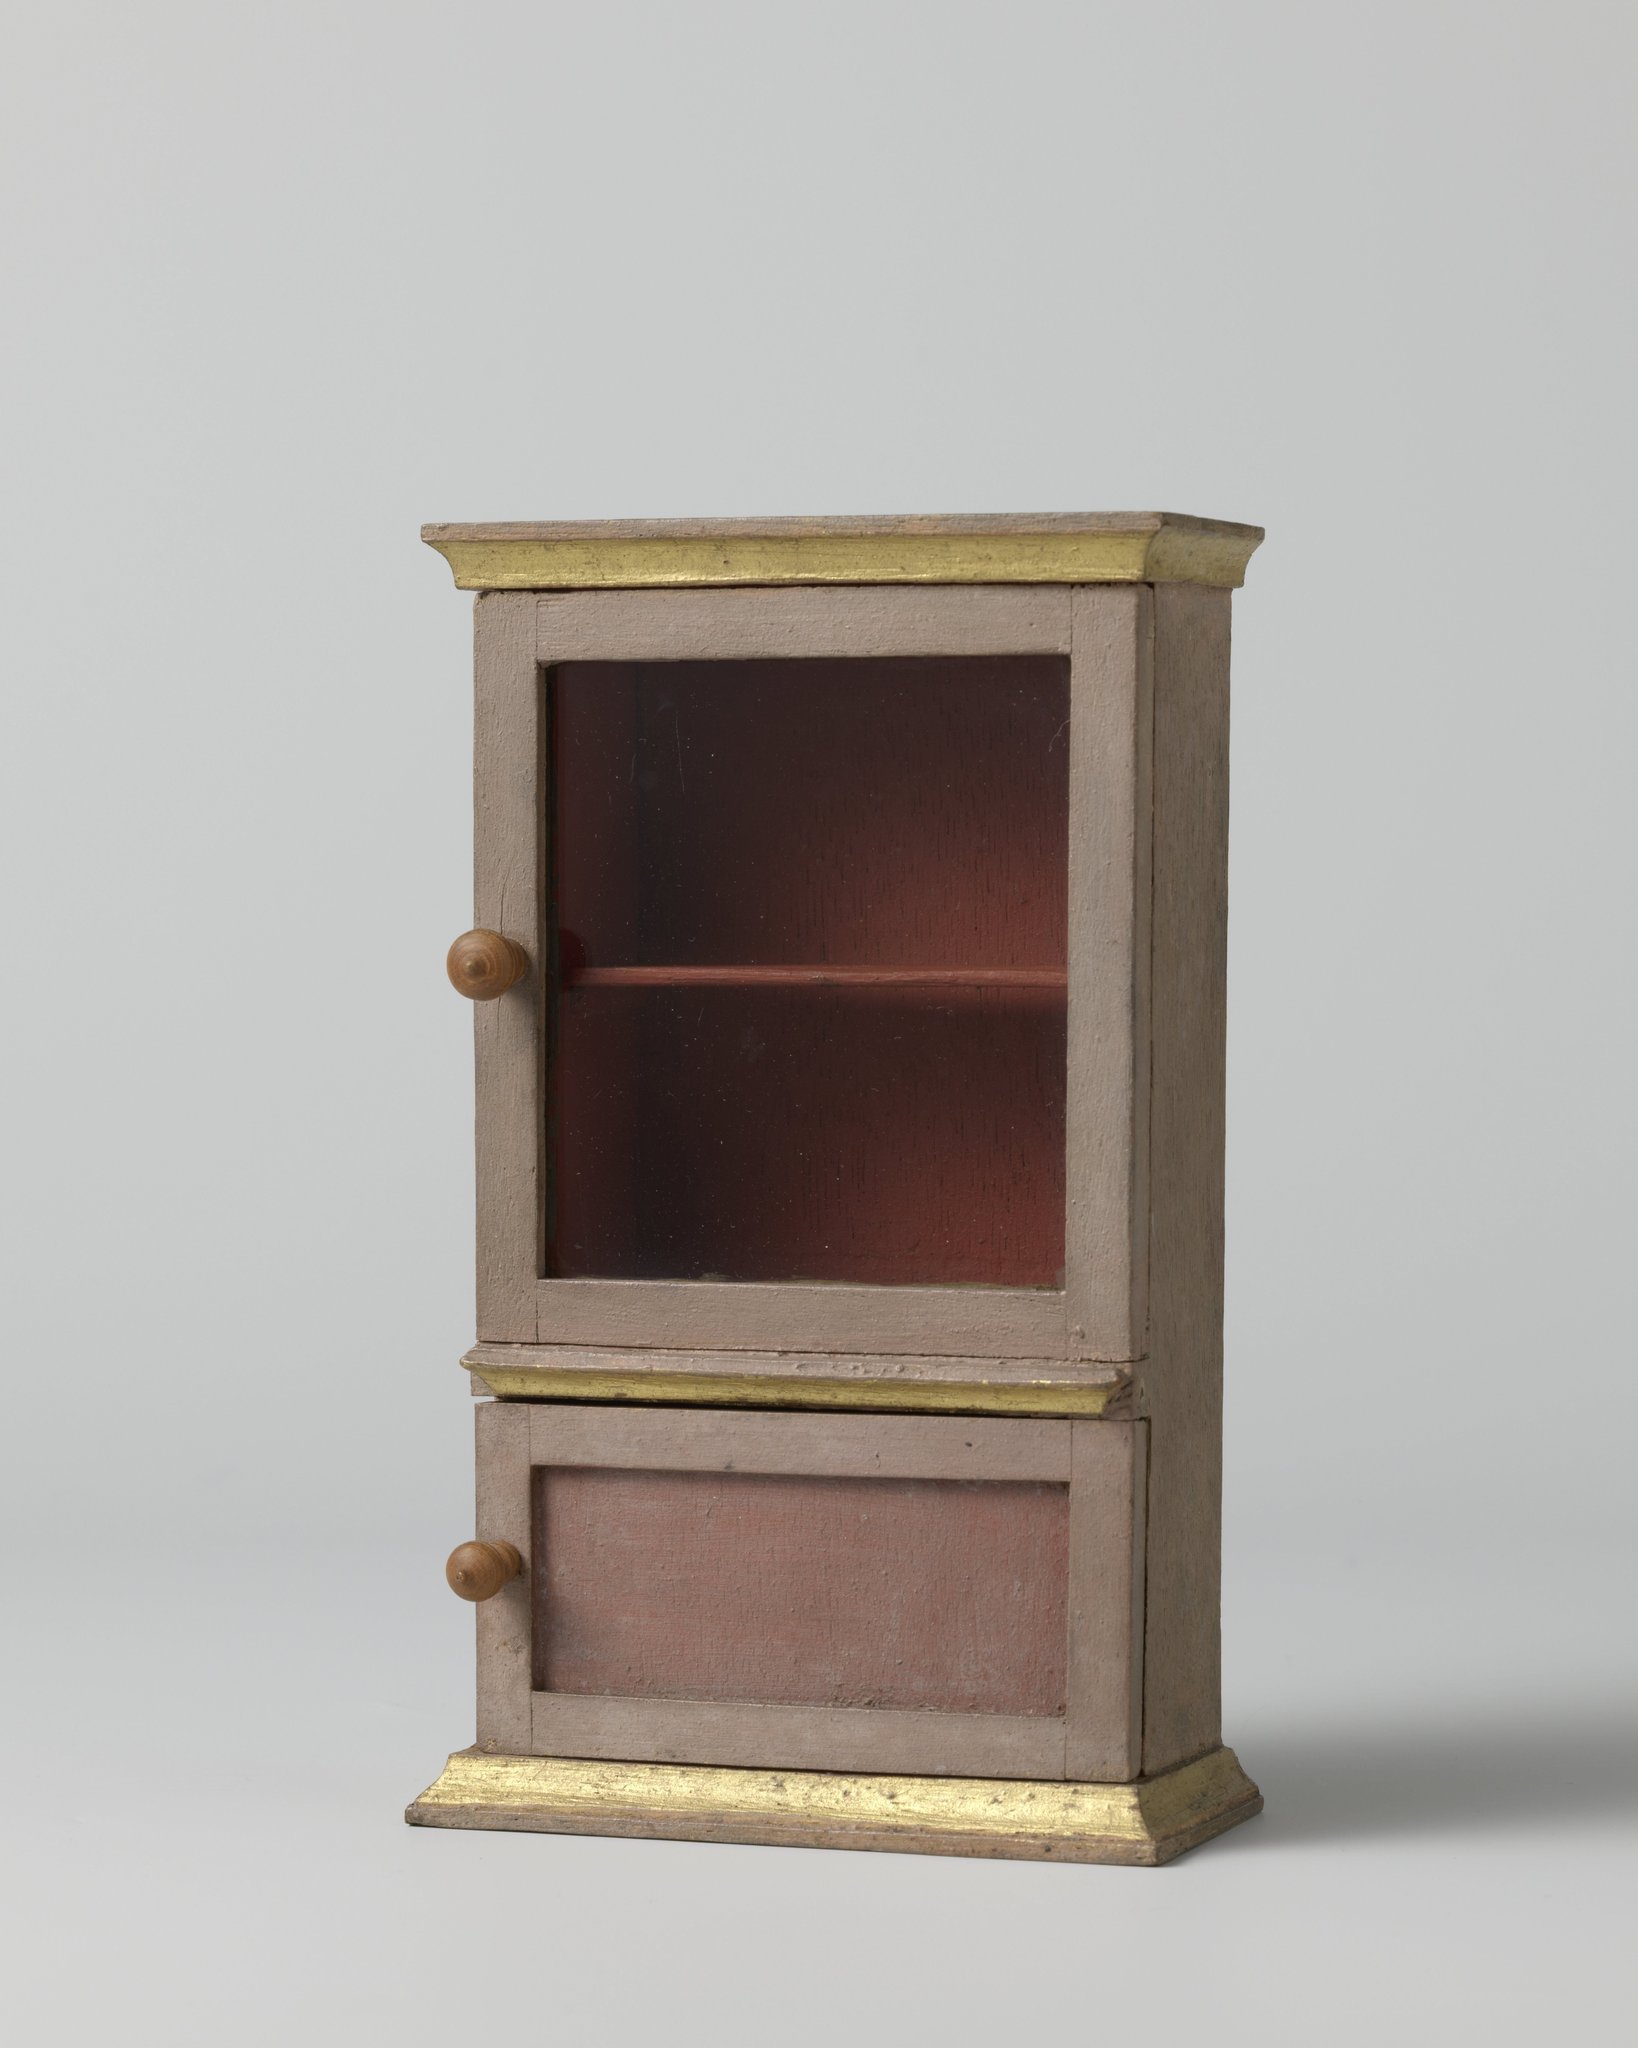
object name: miniature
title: Kast, bestaande uit een boven en onderkast, met glazen bovendeur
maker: Anonymous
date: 1750-1800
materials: wood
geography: amsterdam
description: Hoge kast, vervaardigd van grijs/rood/roze geschilderd eikenhout, bestaande uit een bovenkast met een legplank, en één deur met een glasruit en een onderkast met een dichte deur en een legplank.